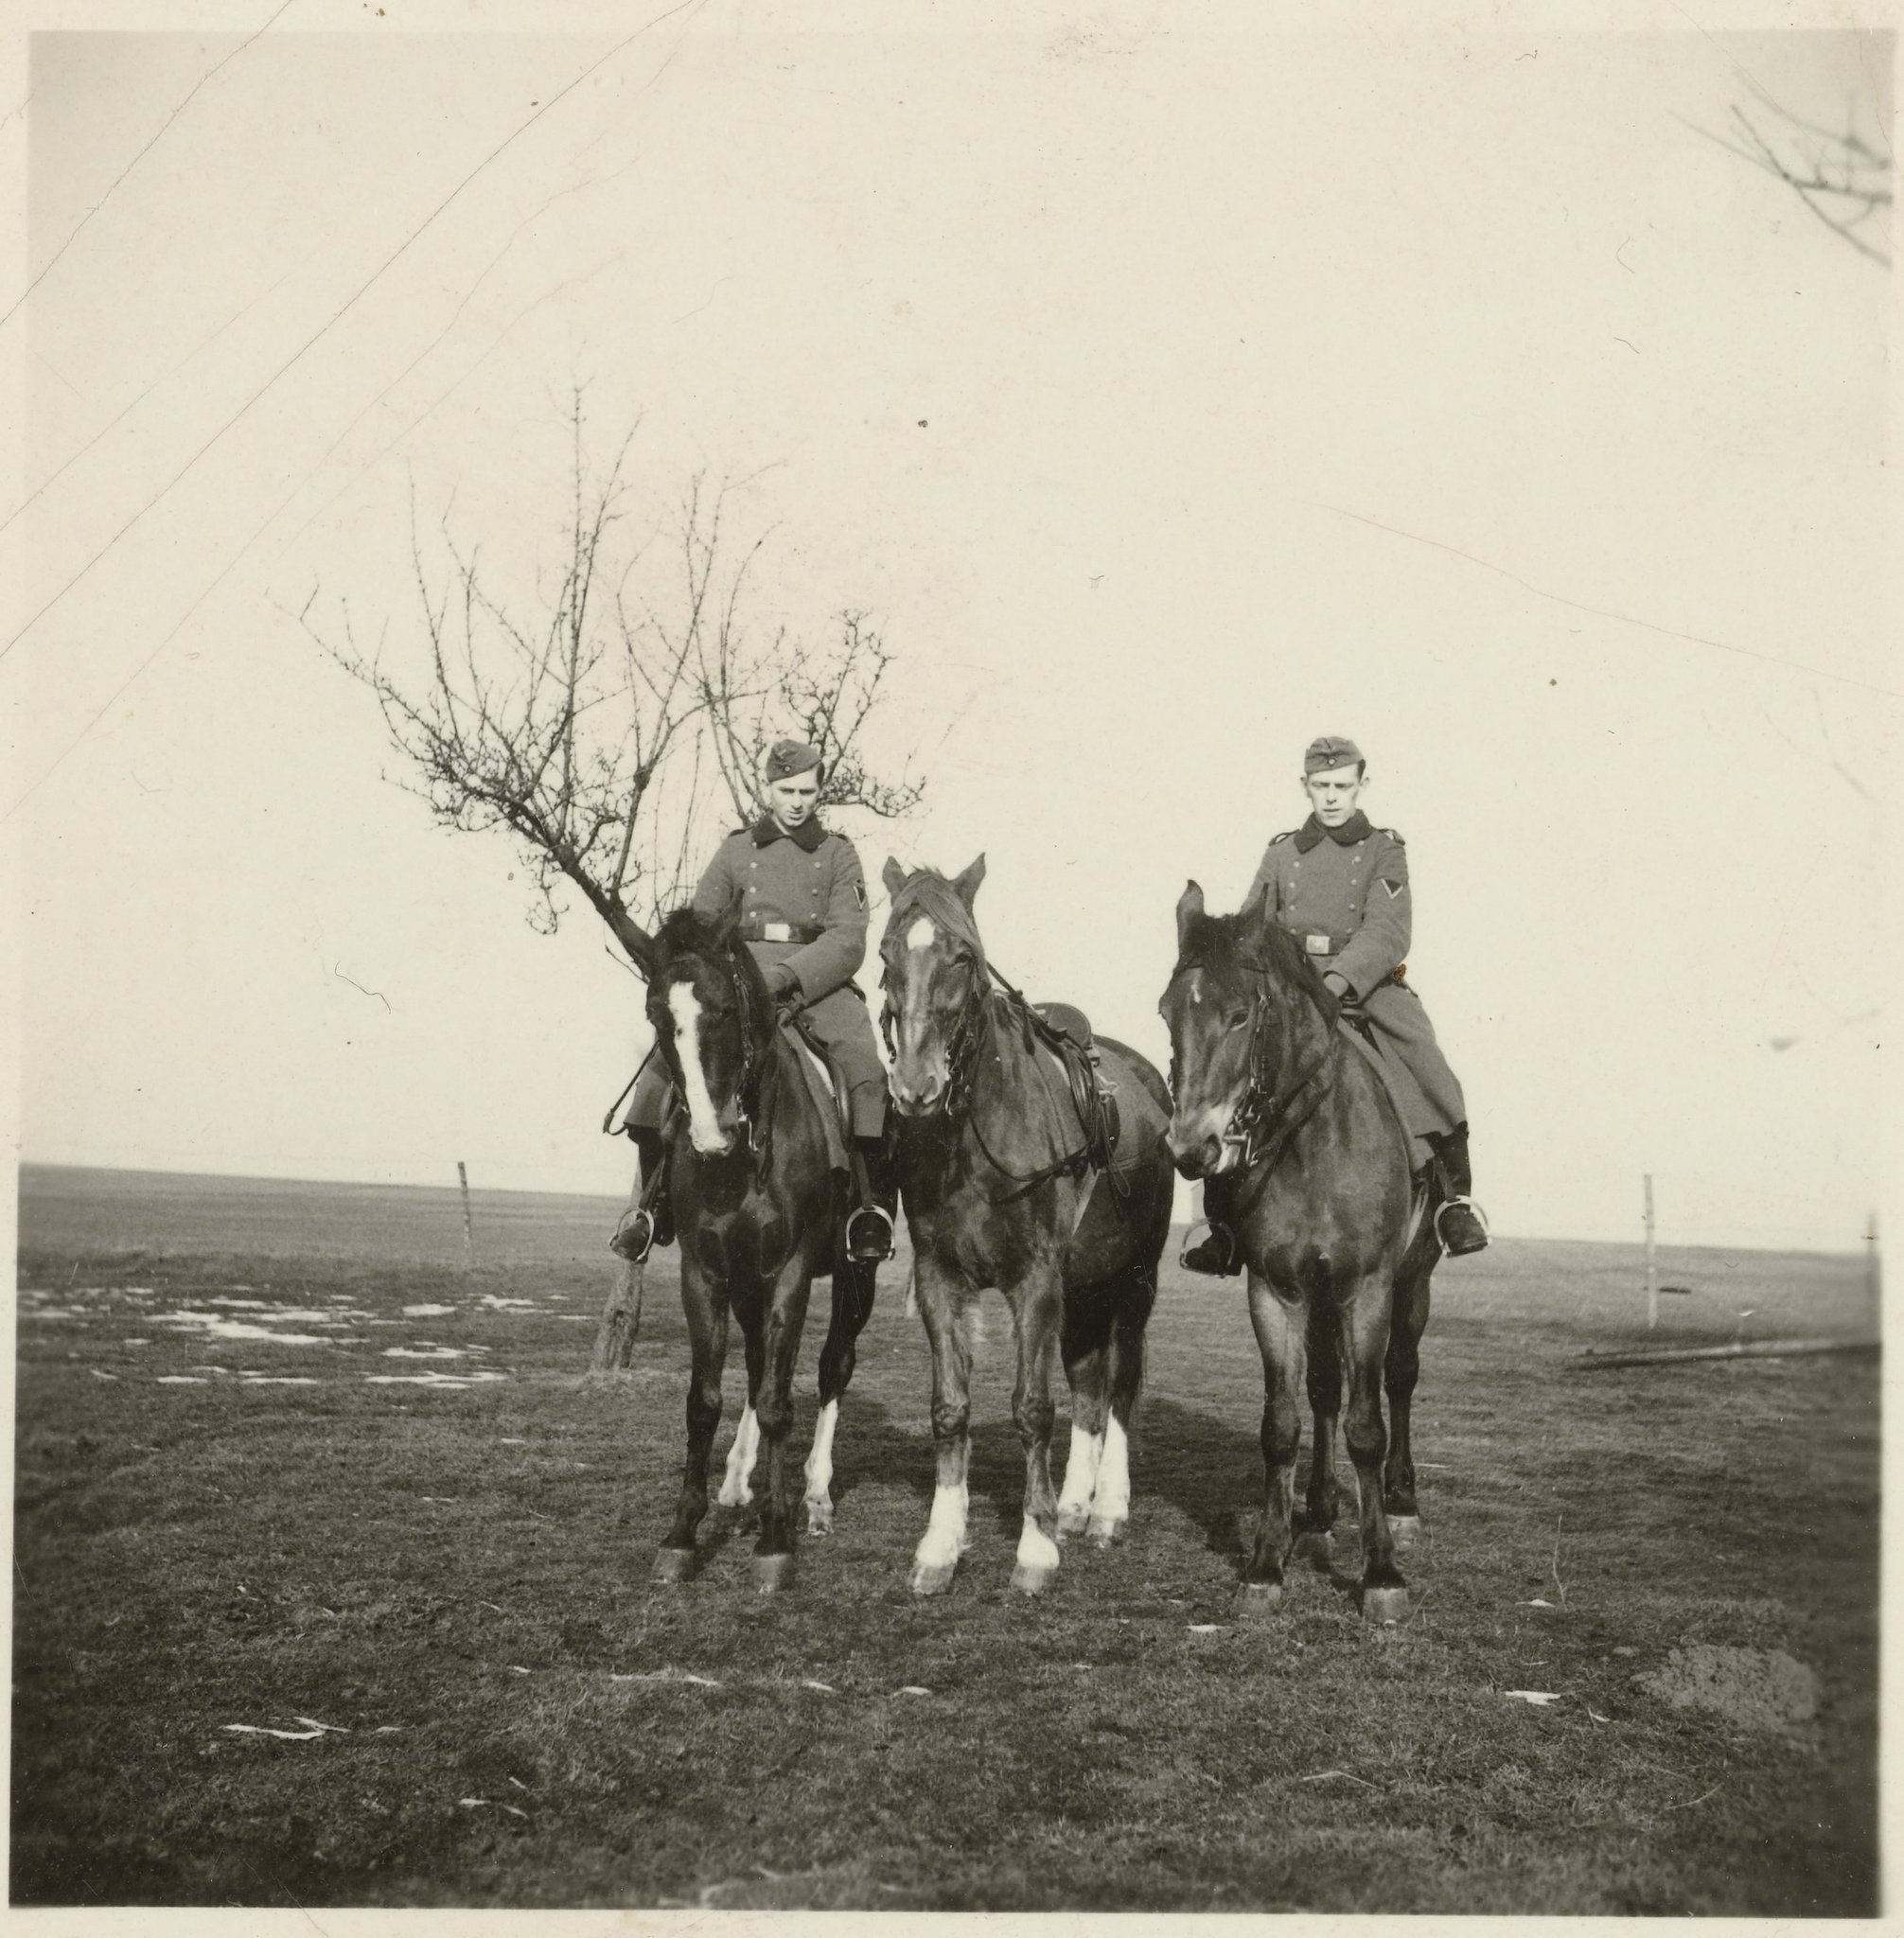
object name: photograph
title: Twee Wehrmachtsoldaten te paard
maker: Anonymous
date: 1940-1945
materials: photographic support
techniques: gelatin silver print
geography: germany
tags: netherlands, germany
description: Twee Wehrmachtsoldaten te paard met een derde paard tussen hen in. Foto behorend bij album 'Kriegserinnerungen'.